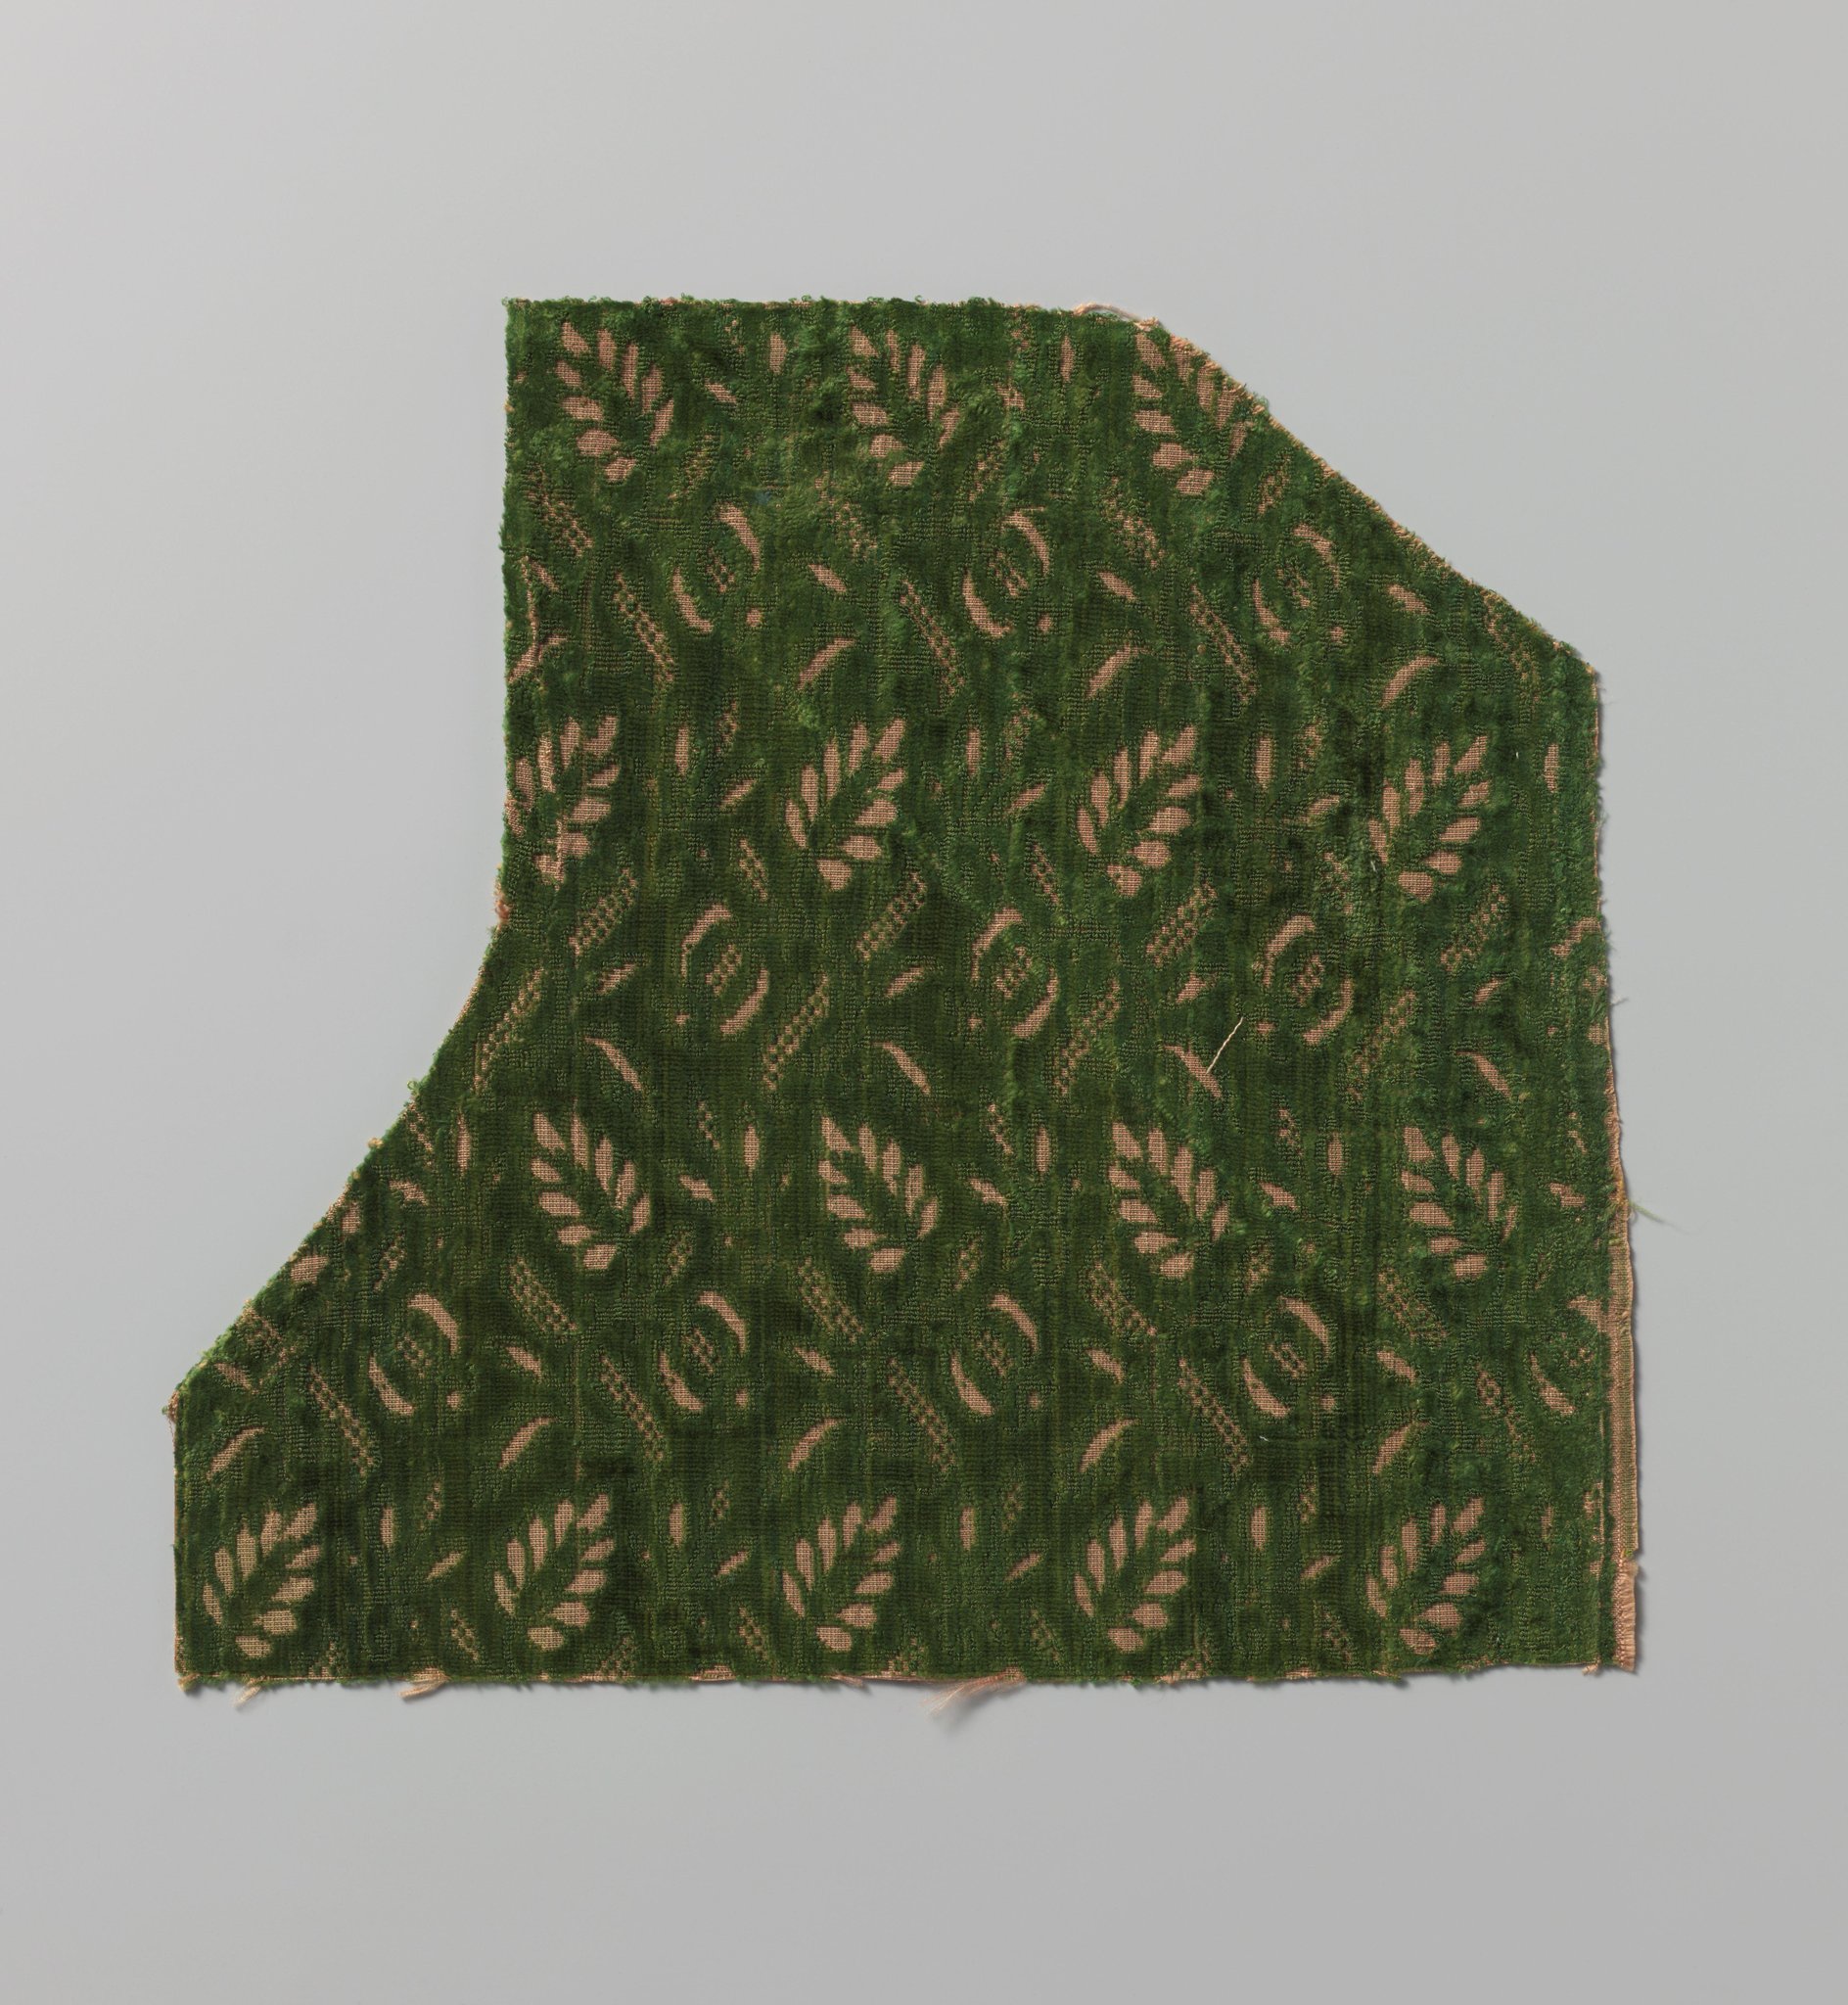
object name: zijdefluweel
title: Fragment groen zijdefluweel met uitsparingen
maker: Anonymous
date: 1500-1599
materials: silk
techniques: velvet, weave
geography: italy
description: Fragment zijdefluweel met op groene fond een patroon van grijde bladeren, afgewisseld met rijen gestileerde palmetten. Het fragment heeft de vorm van een voor- of achterpand.